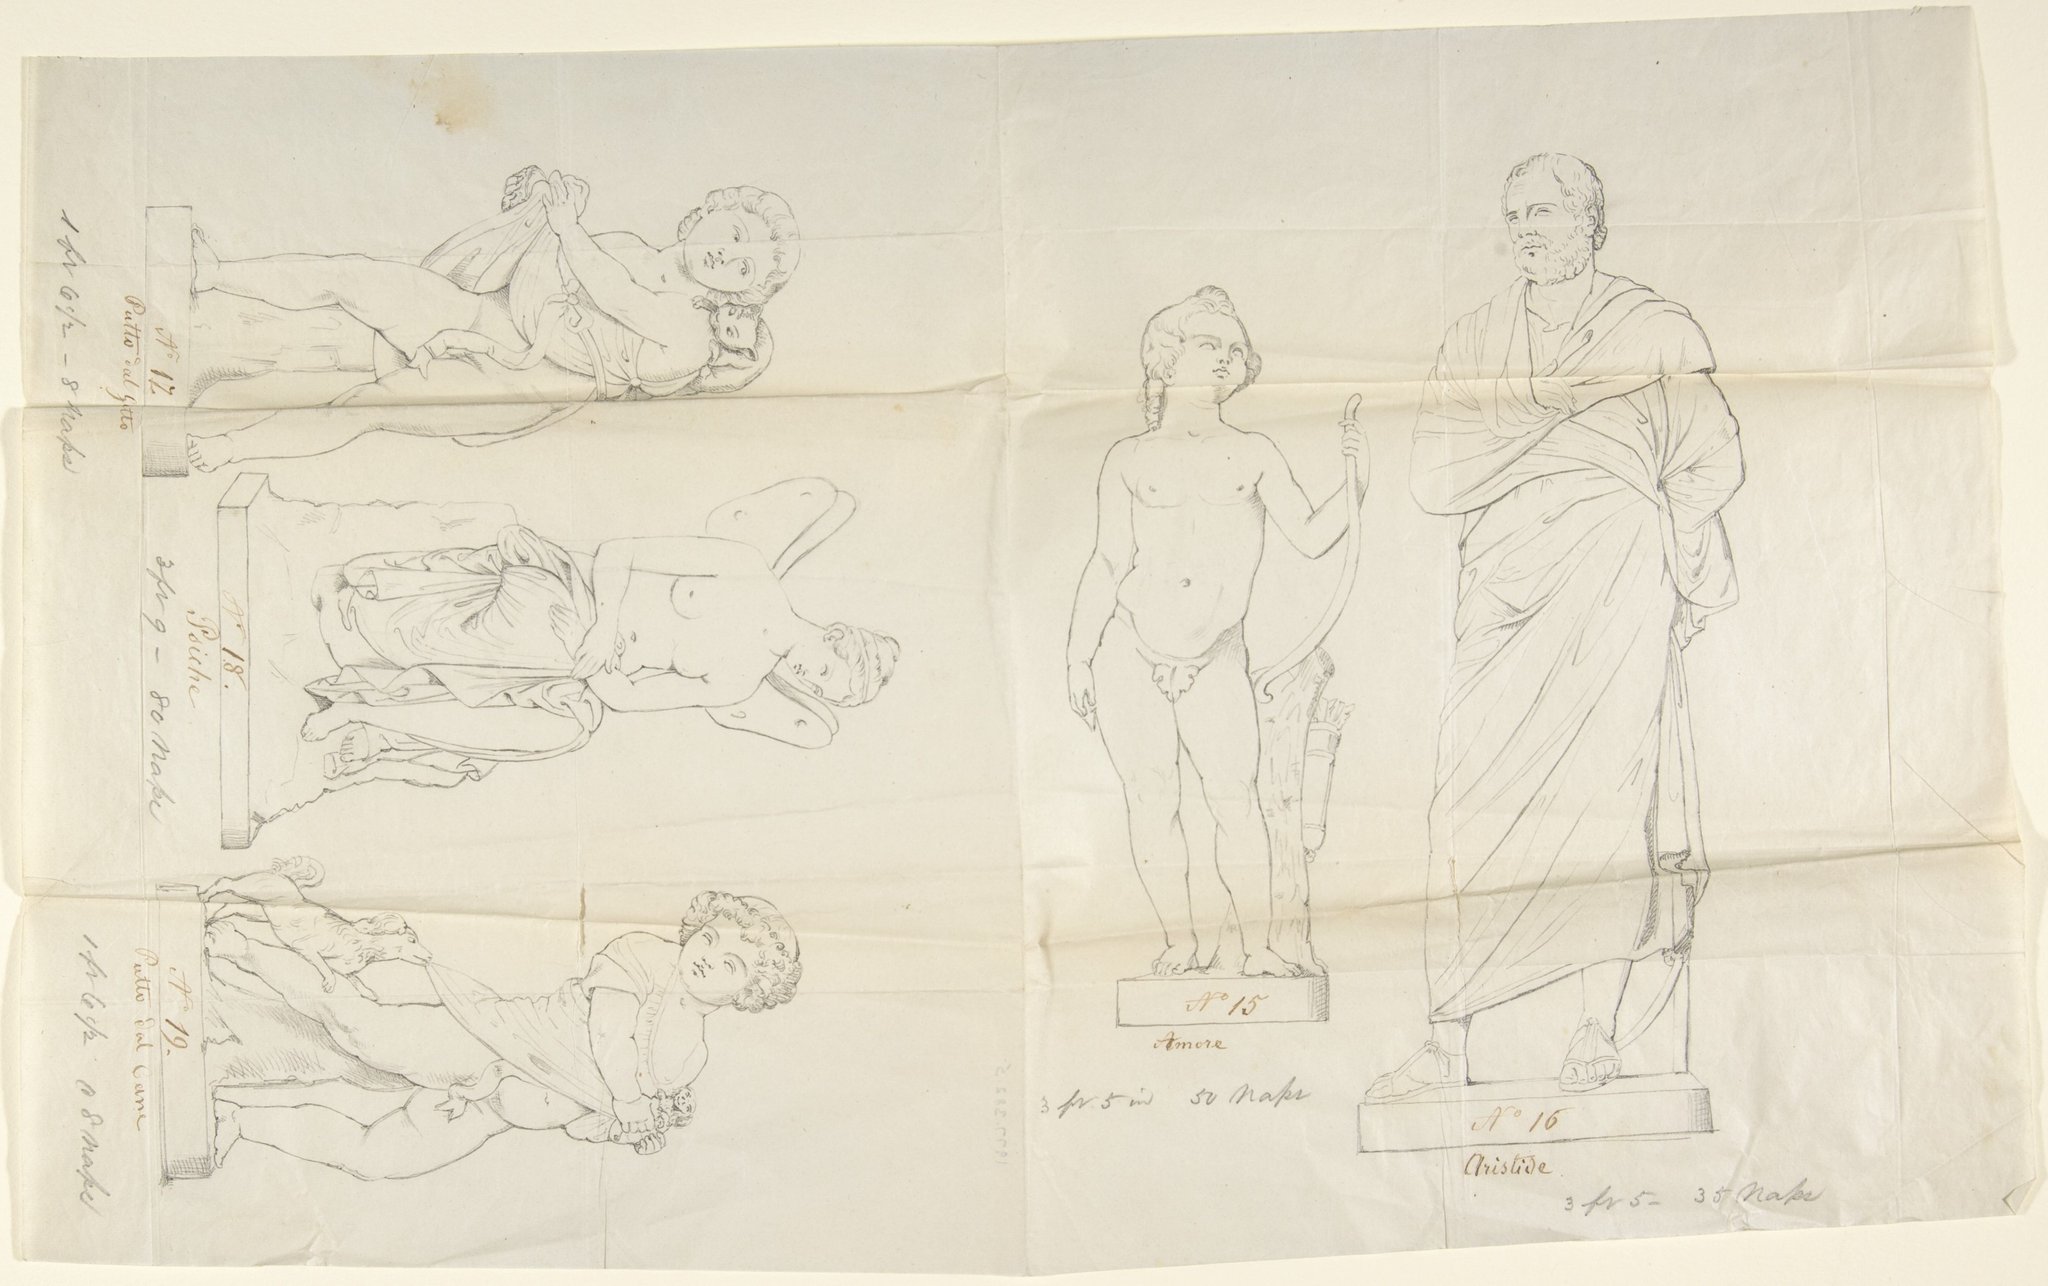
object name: drawing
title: Sketches of five statues: Love, Aristides, Putto with a Cat, Psyche, and Putto with a Dog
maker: john gibson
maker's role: artist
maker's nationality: british, born wales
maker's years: 1790-1866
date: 1850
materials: graphite, ink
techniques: pen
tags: men,cats,dogs